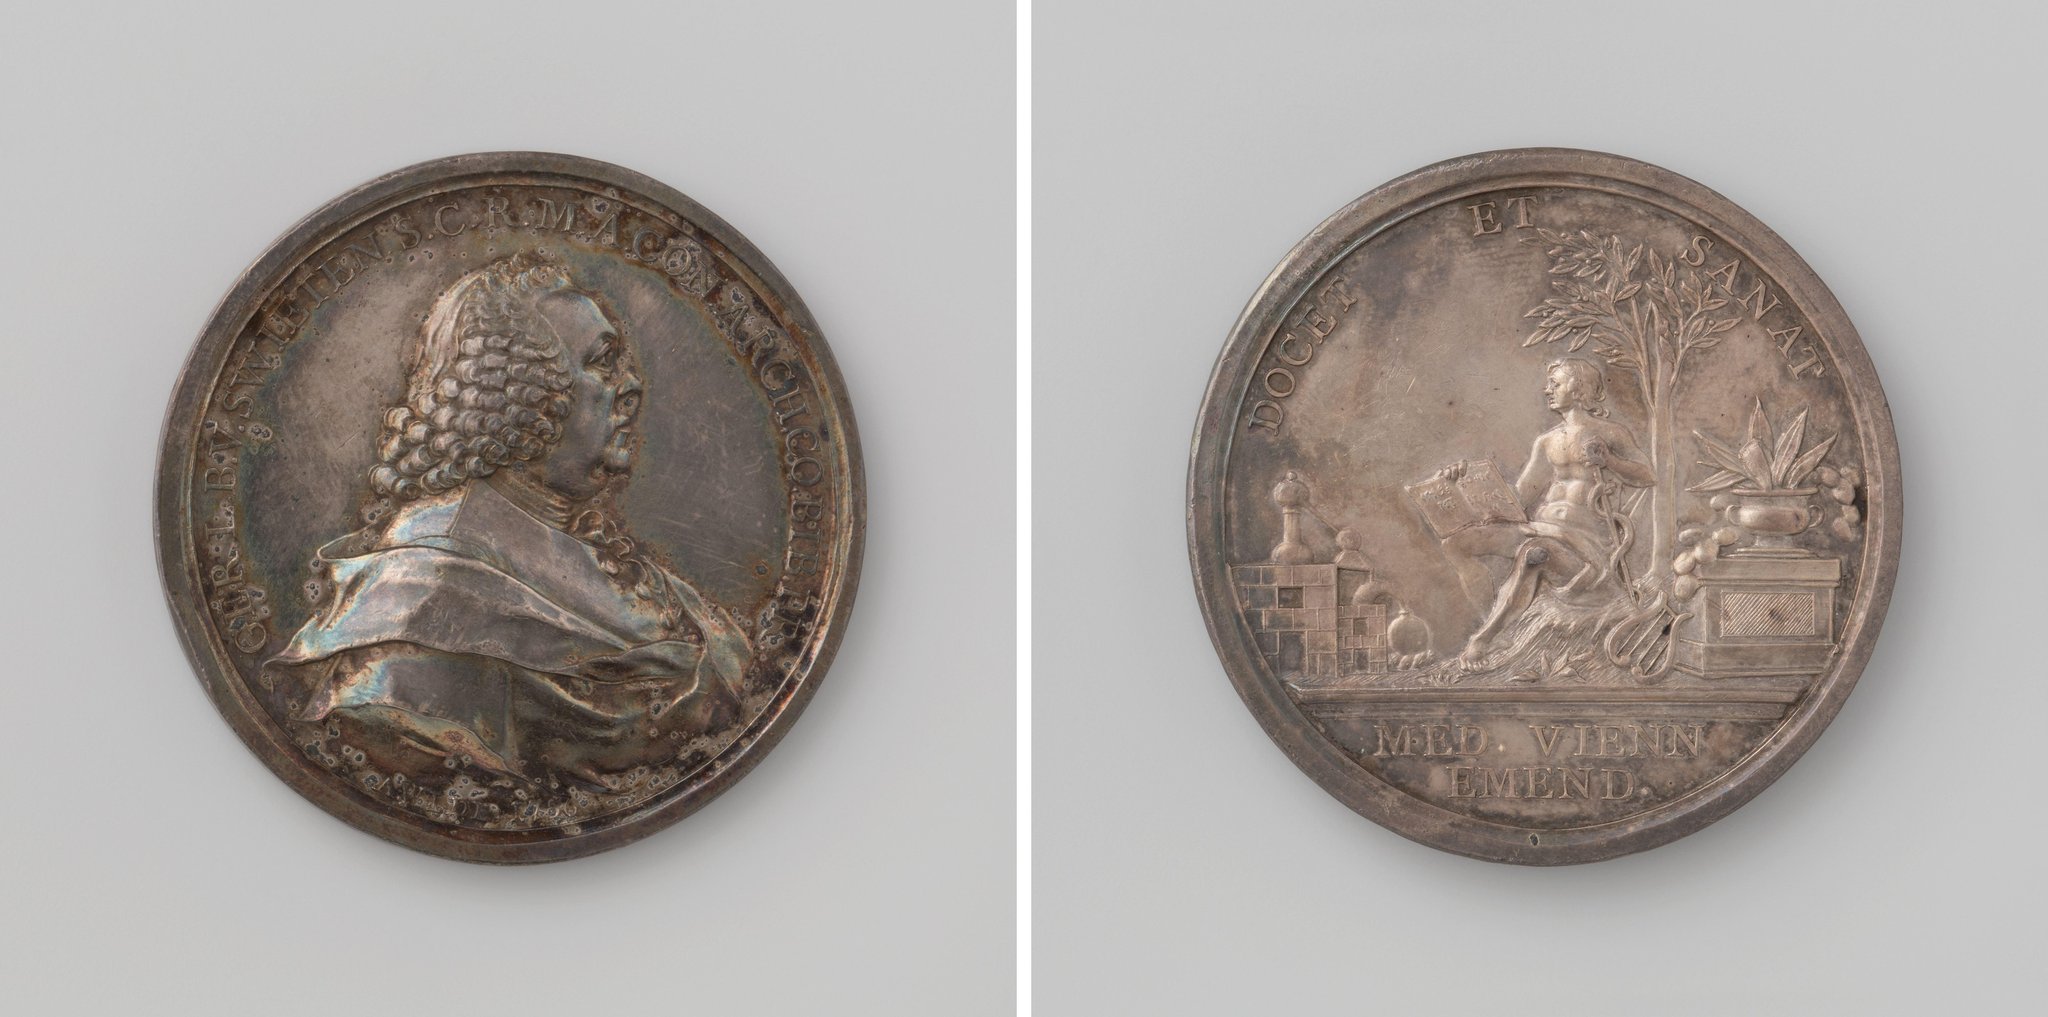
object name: history medal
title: Gerard, baron van Swieten, hofarts en hervormer van de geneeskundige faculteit te Wenen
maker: anton franz widemann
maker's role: medailleur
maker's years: 1724-1792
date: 1756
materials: silver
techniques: striking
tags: leiden, vienna